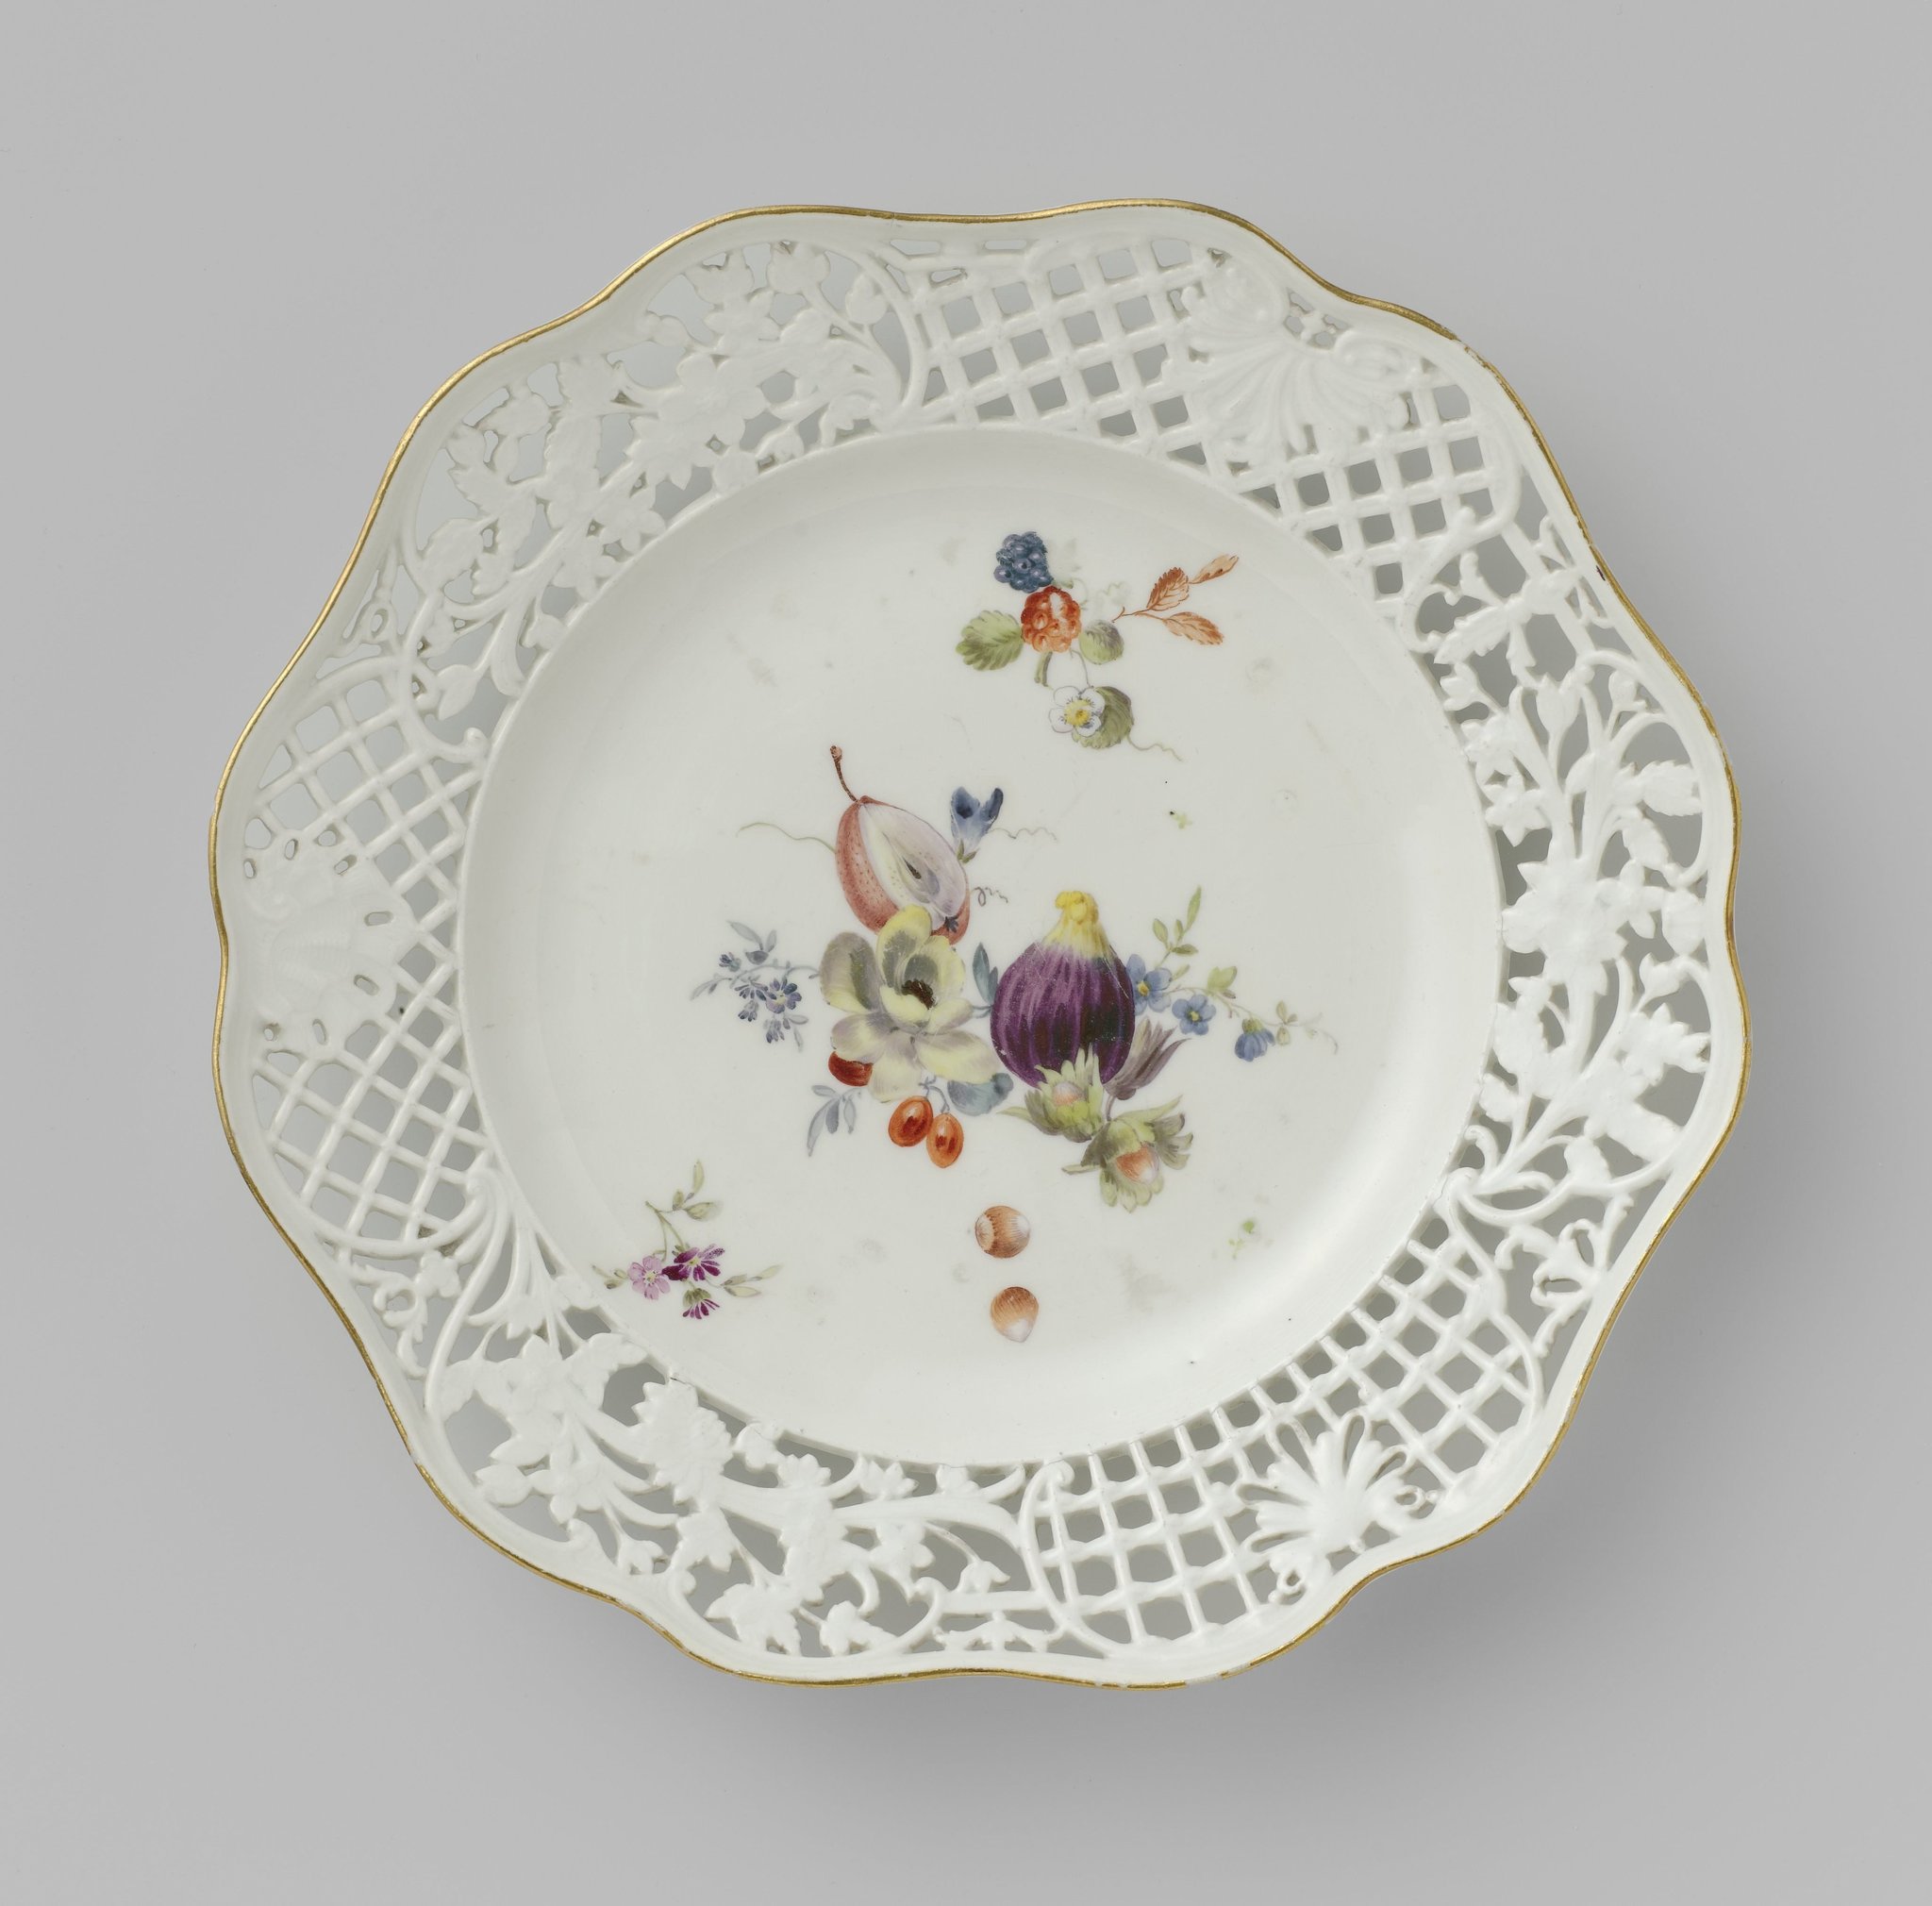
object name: eating drinking utensil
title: Dessertbord, veelkleurig beschilderd met bloemen en vruchten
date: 1750-1760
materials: porcelain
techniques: painted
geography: meissen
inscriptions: factory mark, mold mark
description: Rond dessertbord van beschilderd porselein. De geschulpte rand is opengewerkt met afwisselend een netwerk met een palmet en takken met bladeren en bloemen. De spiegel is beschilderd met bloemen en vruchten. Het bord is gemerkt.